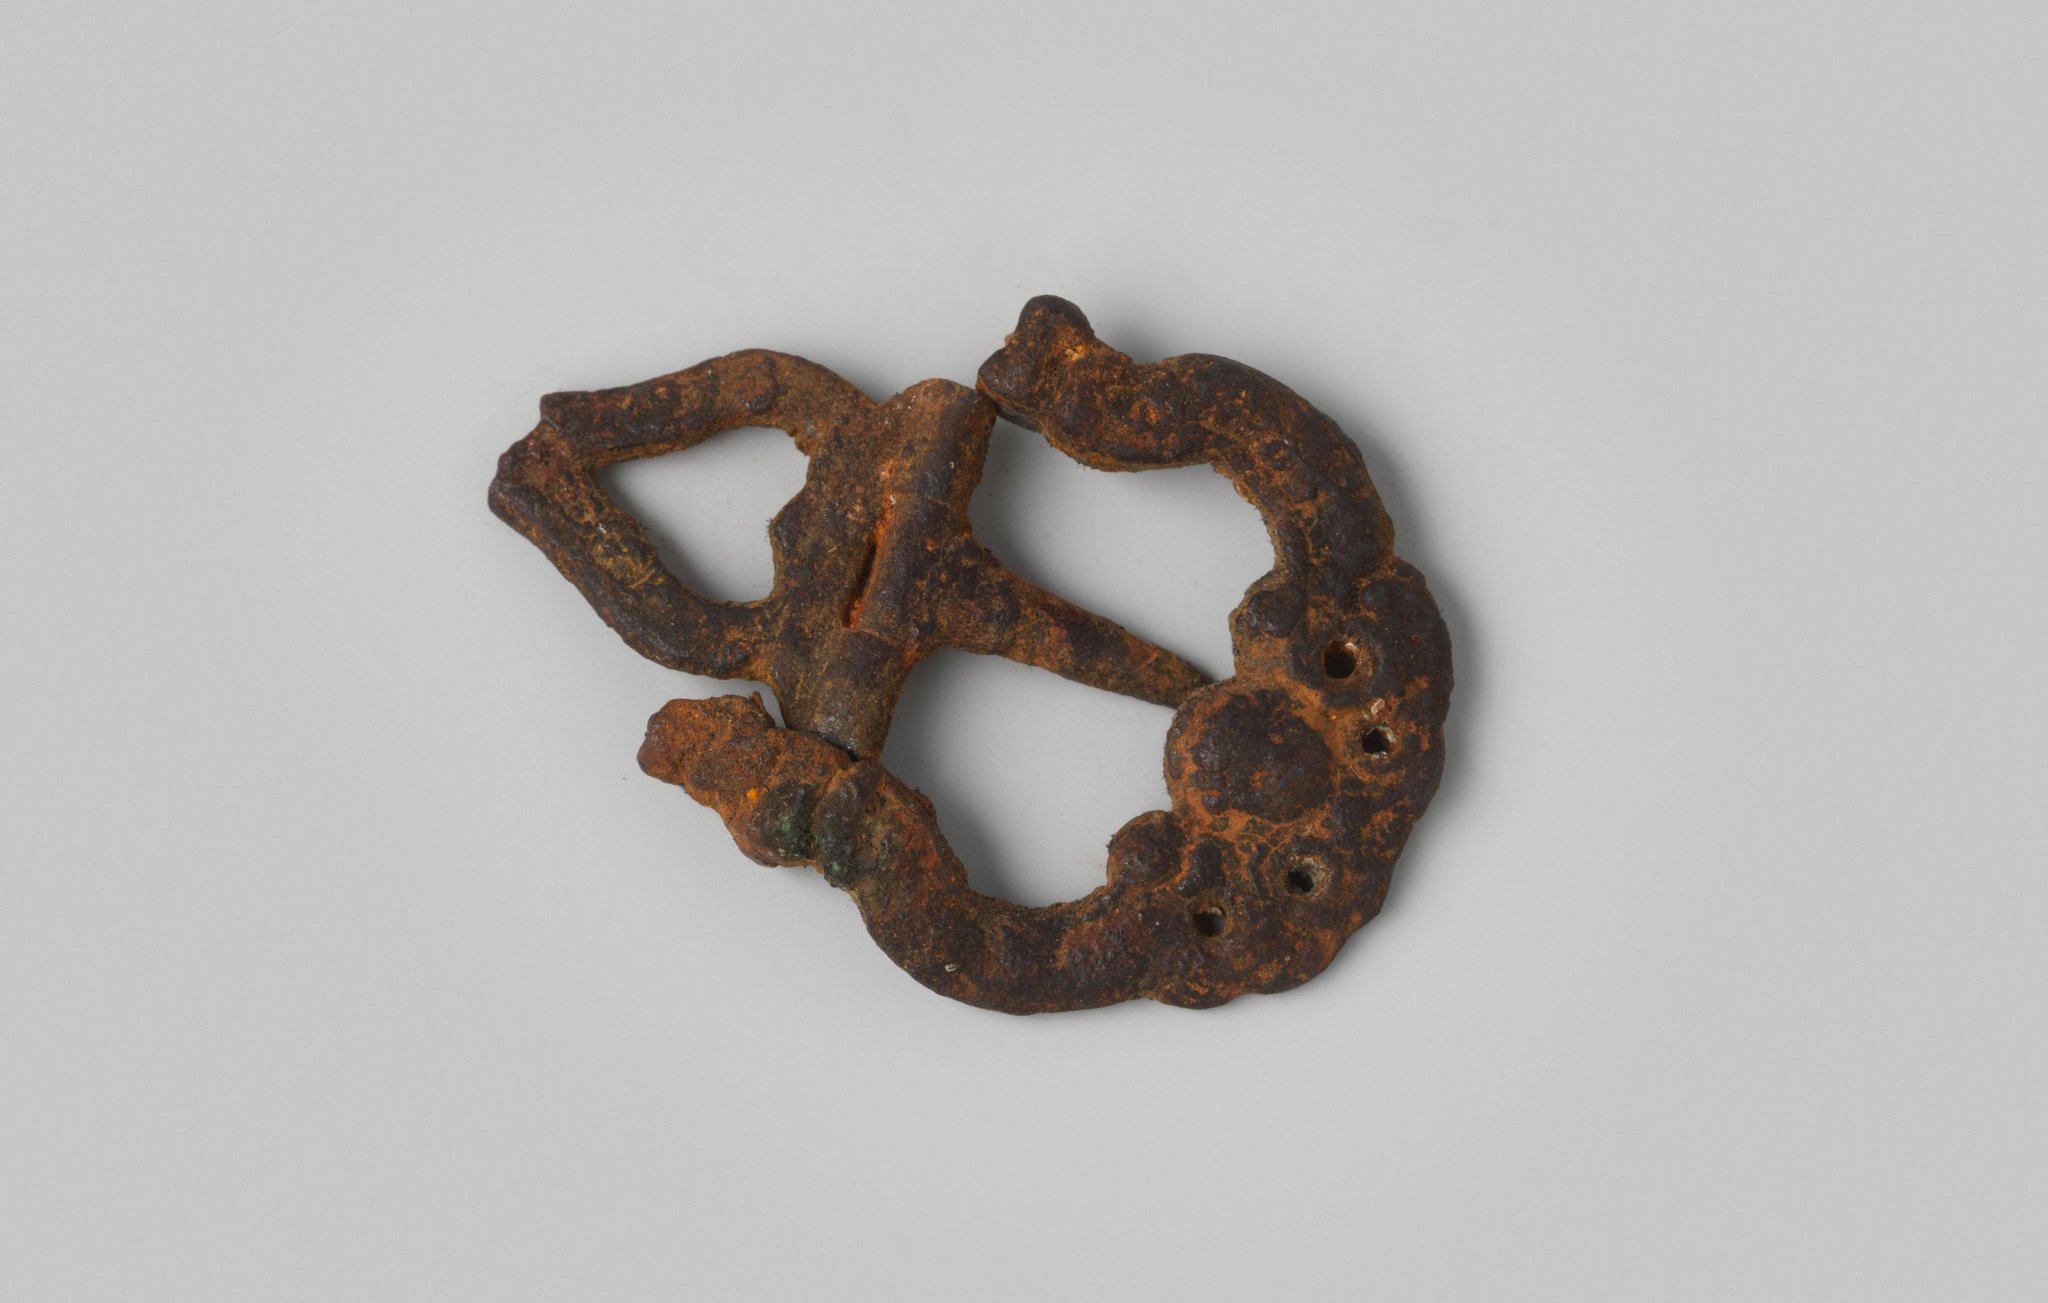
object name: shoe buckle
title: Schoengesp uit het wrak van de Oost-Indiëvaarder Hollandia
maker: Anonymous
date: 1700-1743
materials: copper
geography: netherlands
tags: verenigde oostindische compagnie, hollandia (schip), annet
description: Buckle, chape buckle, shoe buckle; fragment, eroded: half ring broken, oval outline, moulded, pierced, tongue, anchor chape, broken.